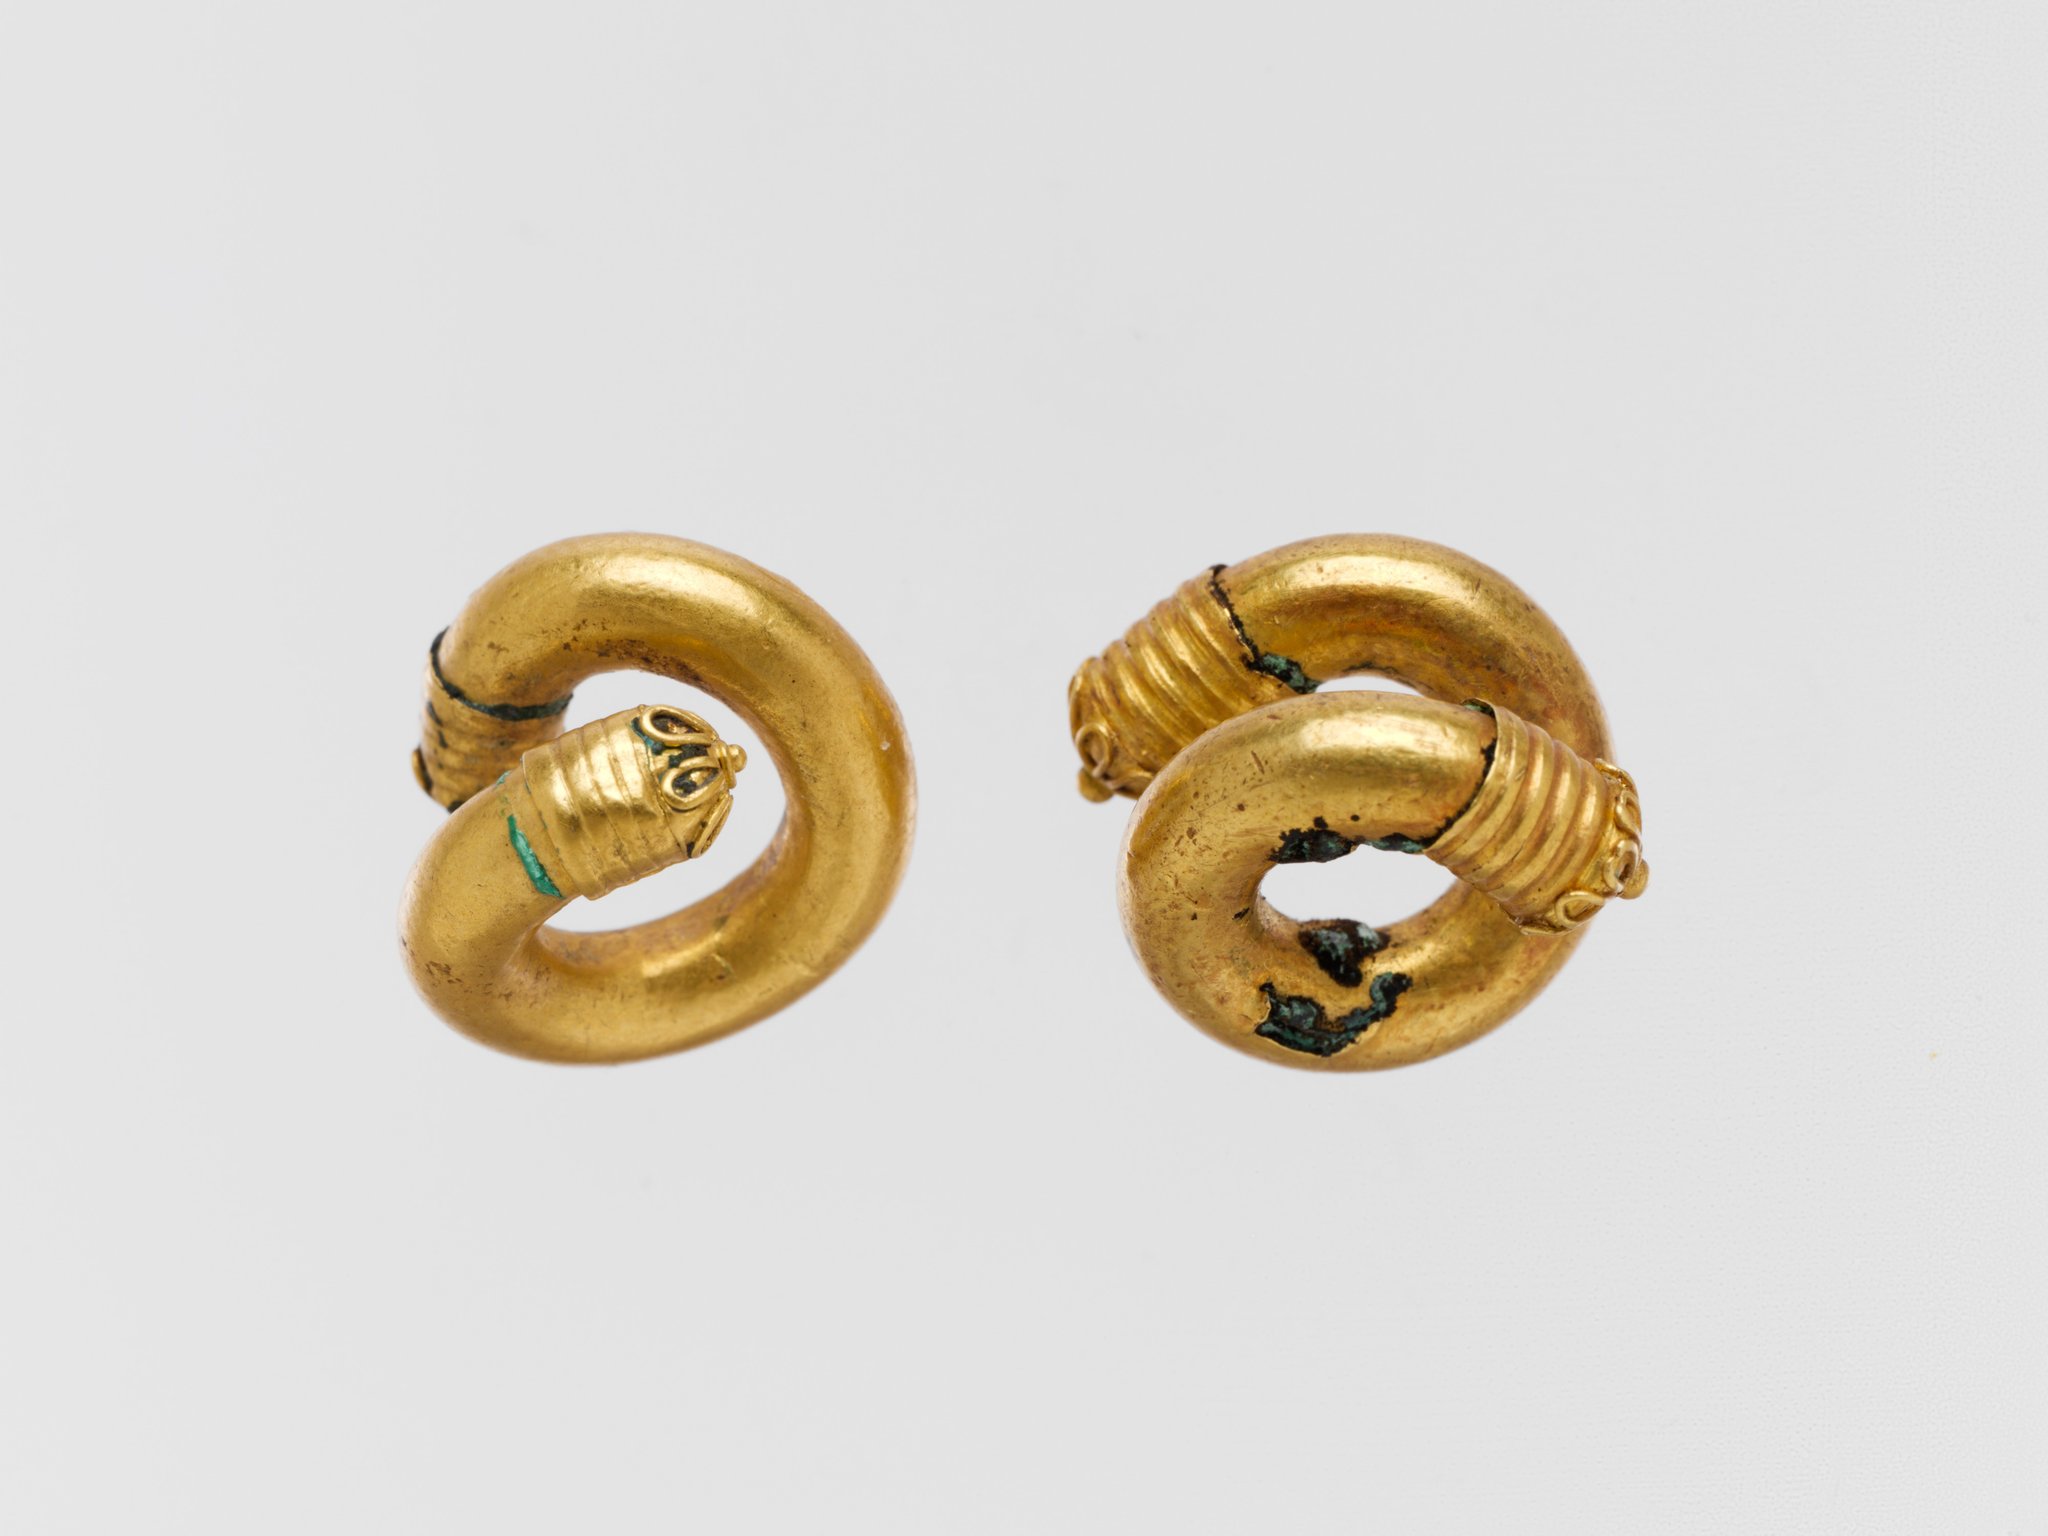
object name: earring, spiral with rosette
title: Gold and copper alloy spiral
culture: cypriot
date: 500-401 BCE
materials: bronze, gold